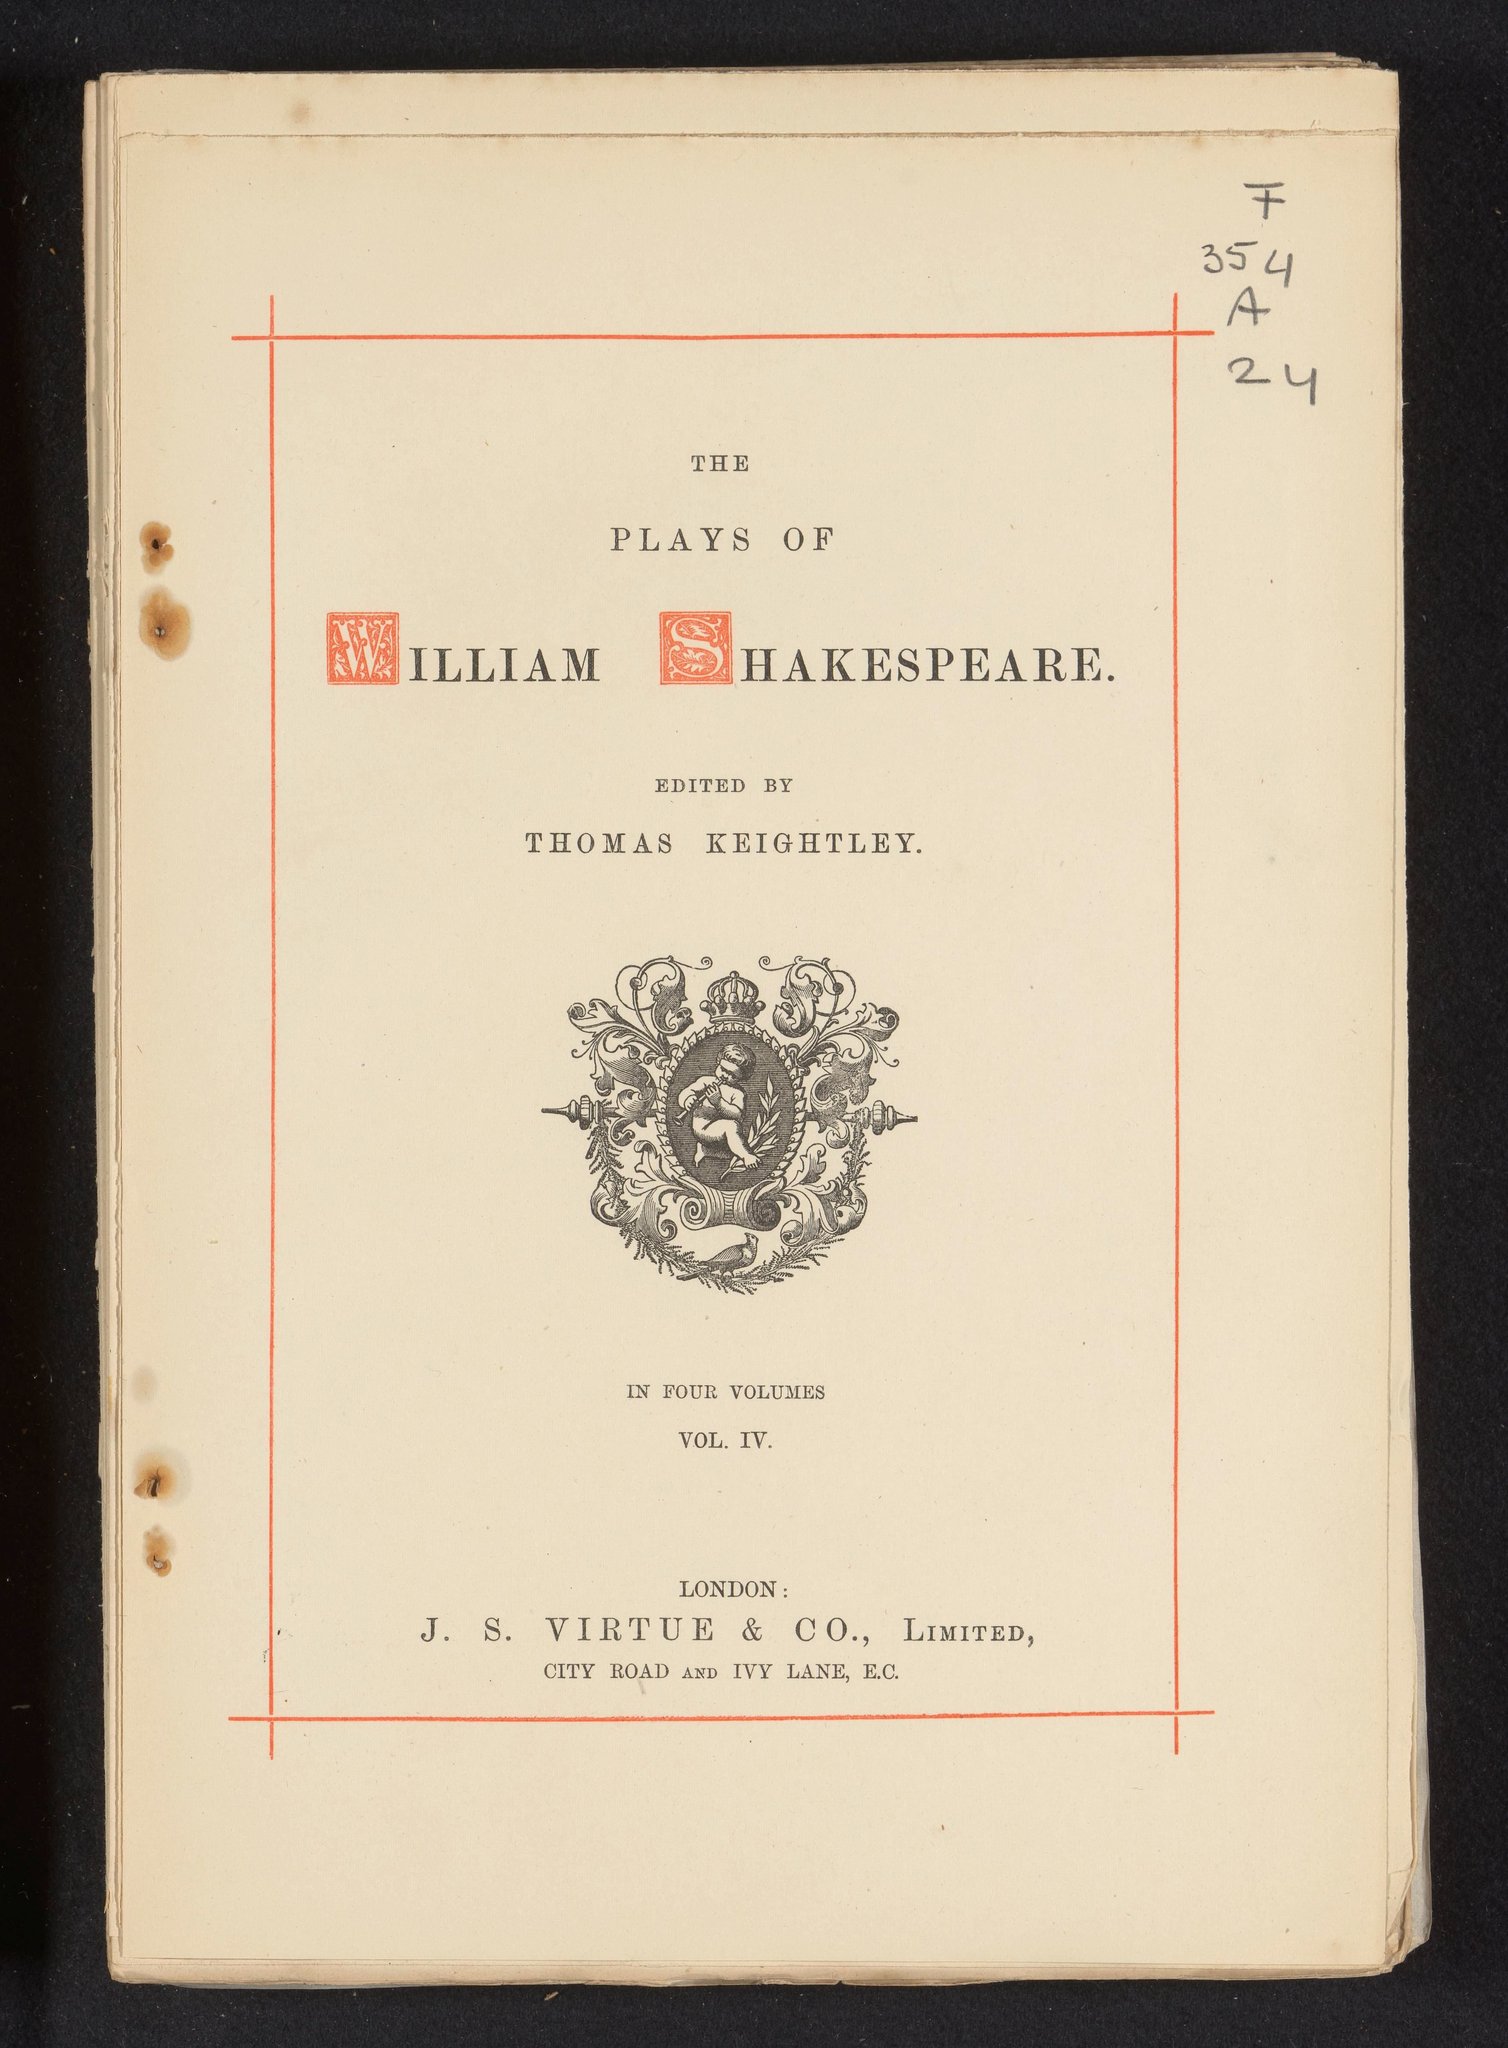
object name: book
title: The plays of William Shakespeare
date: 1890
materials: paper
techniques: photoaquatint, printing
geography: london